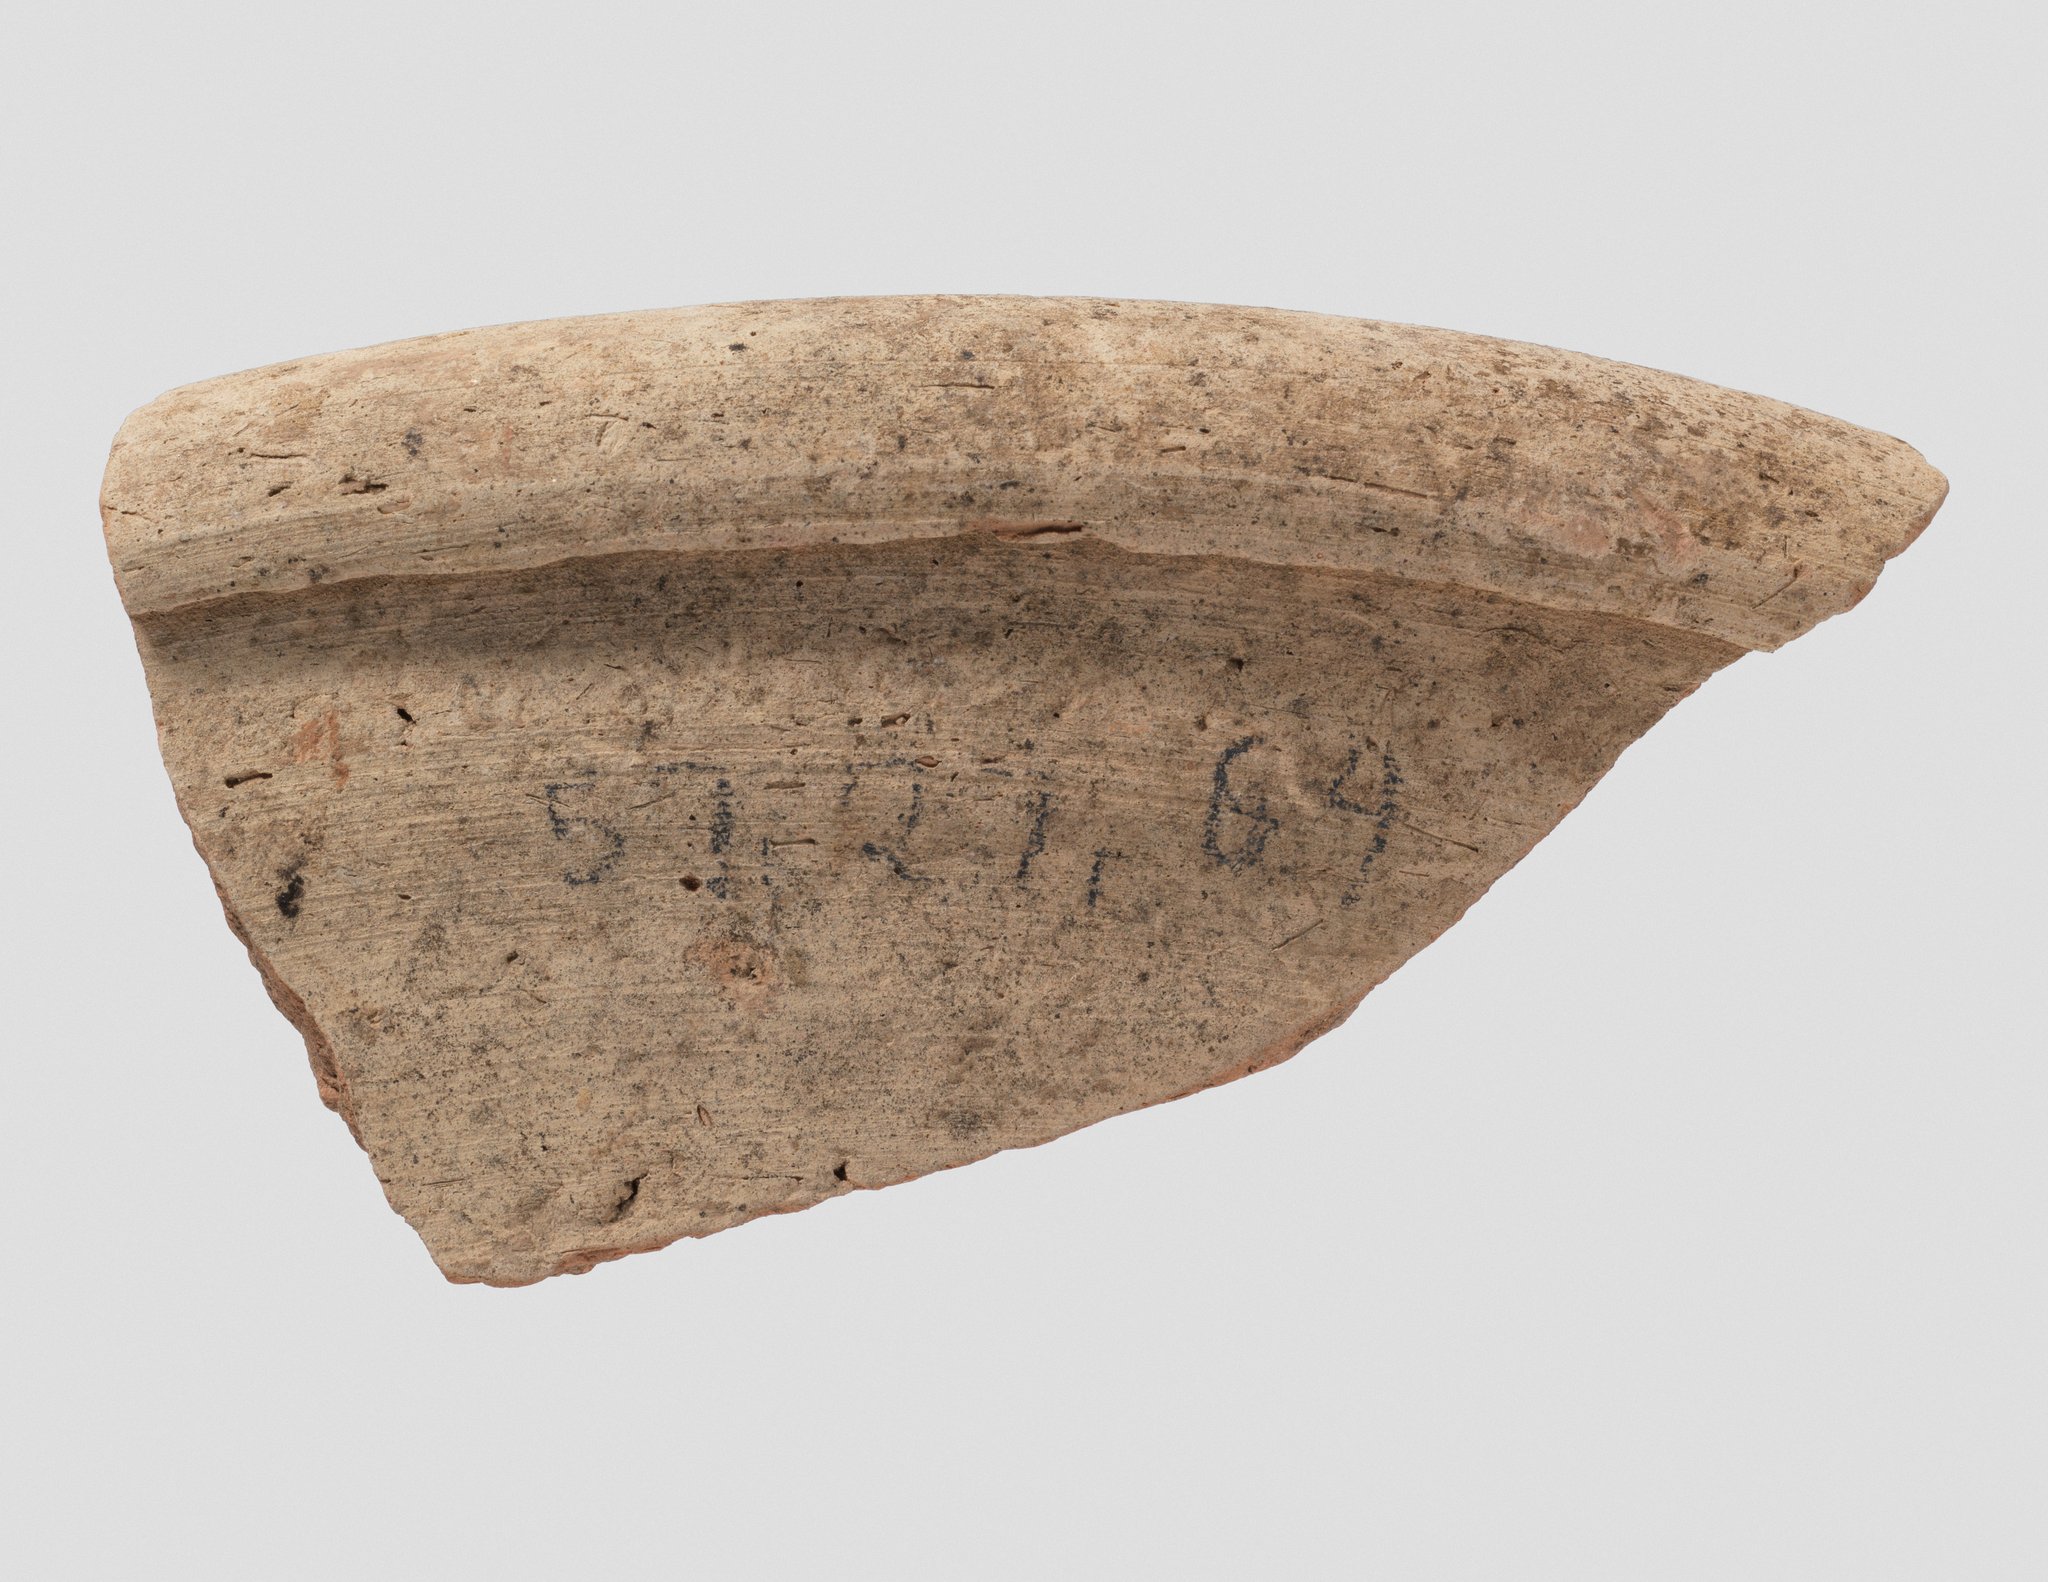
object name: sherd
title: Rim sherd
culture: assyrian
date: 800-601 BCE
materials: ceramic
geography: mesopotamia